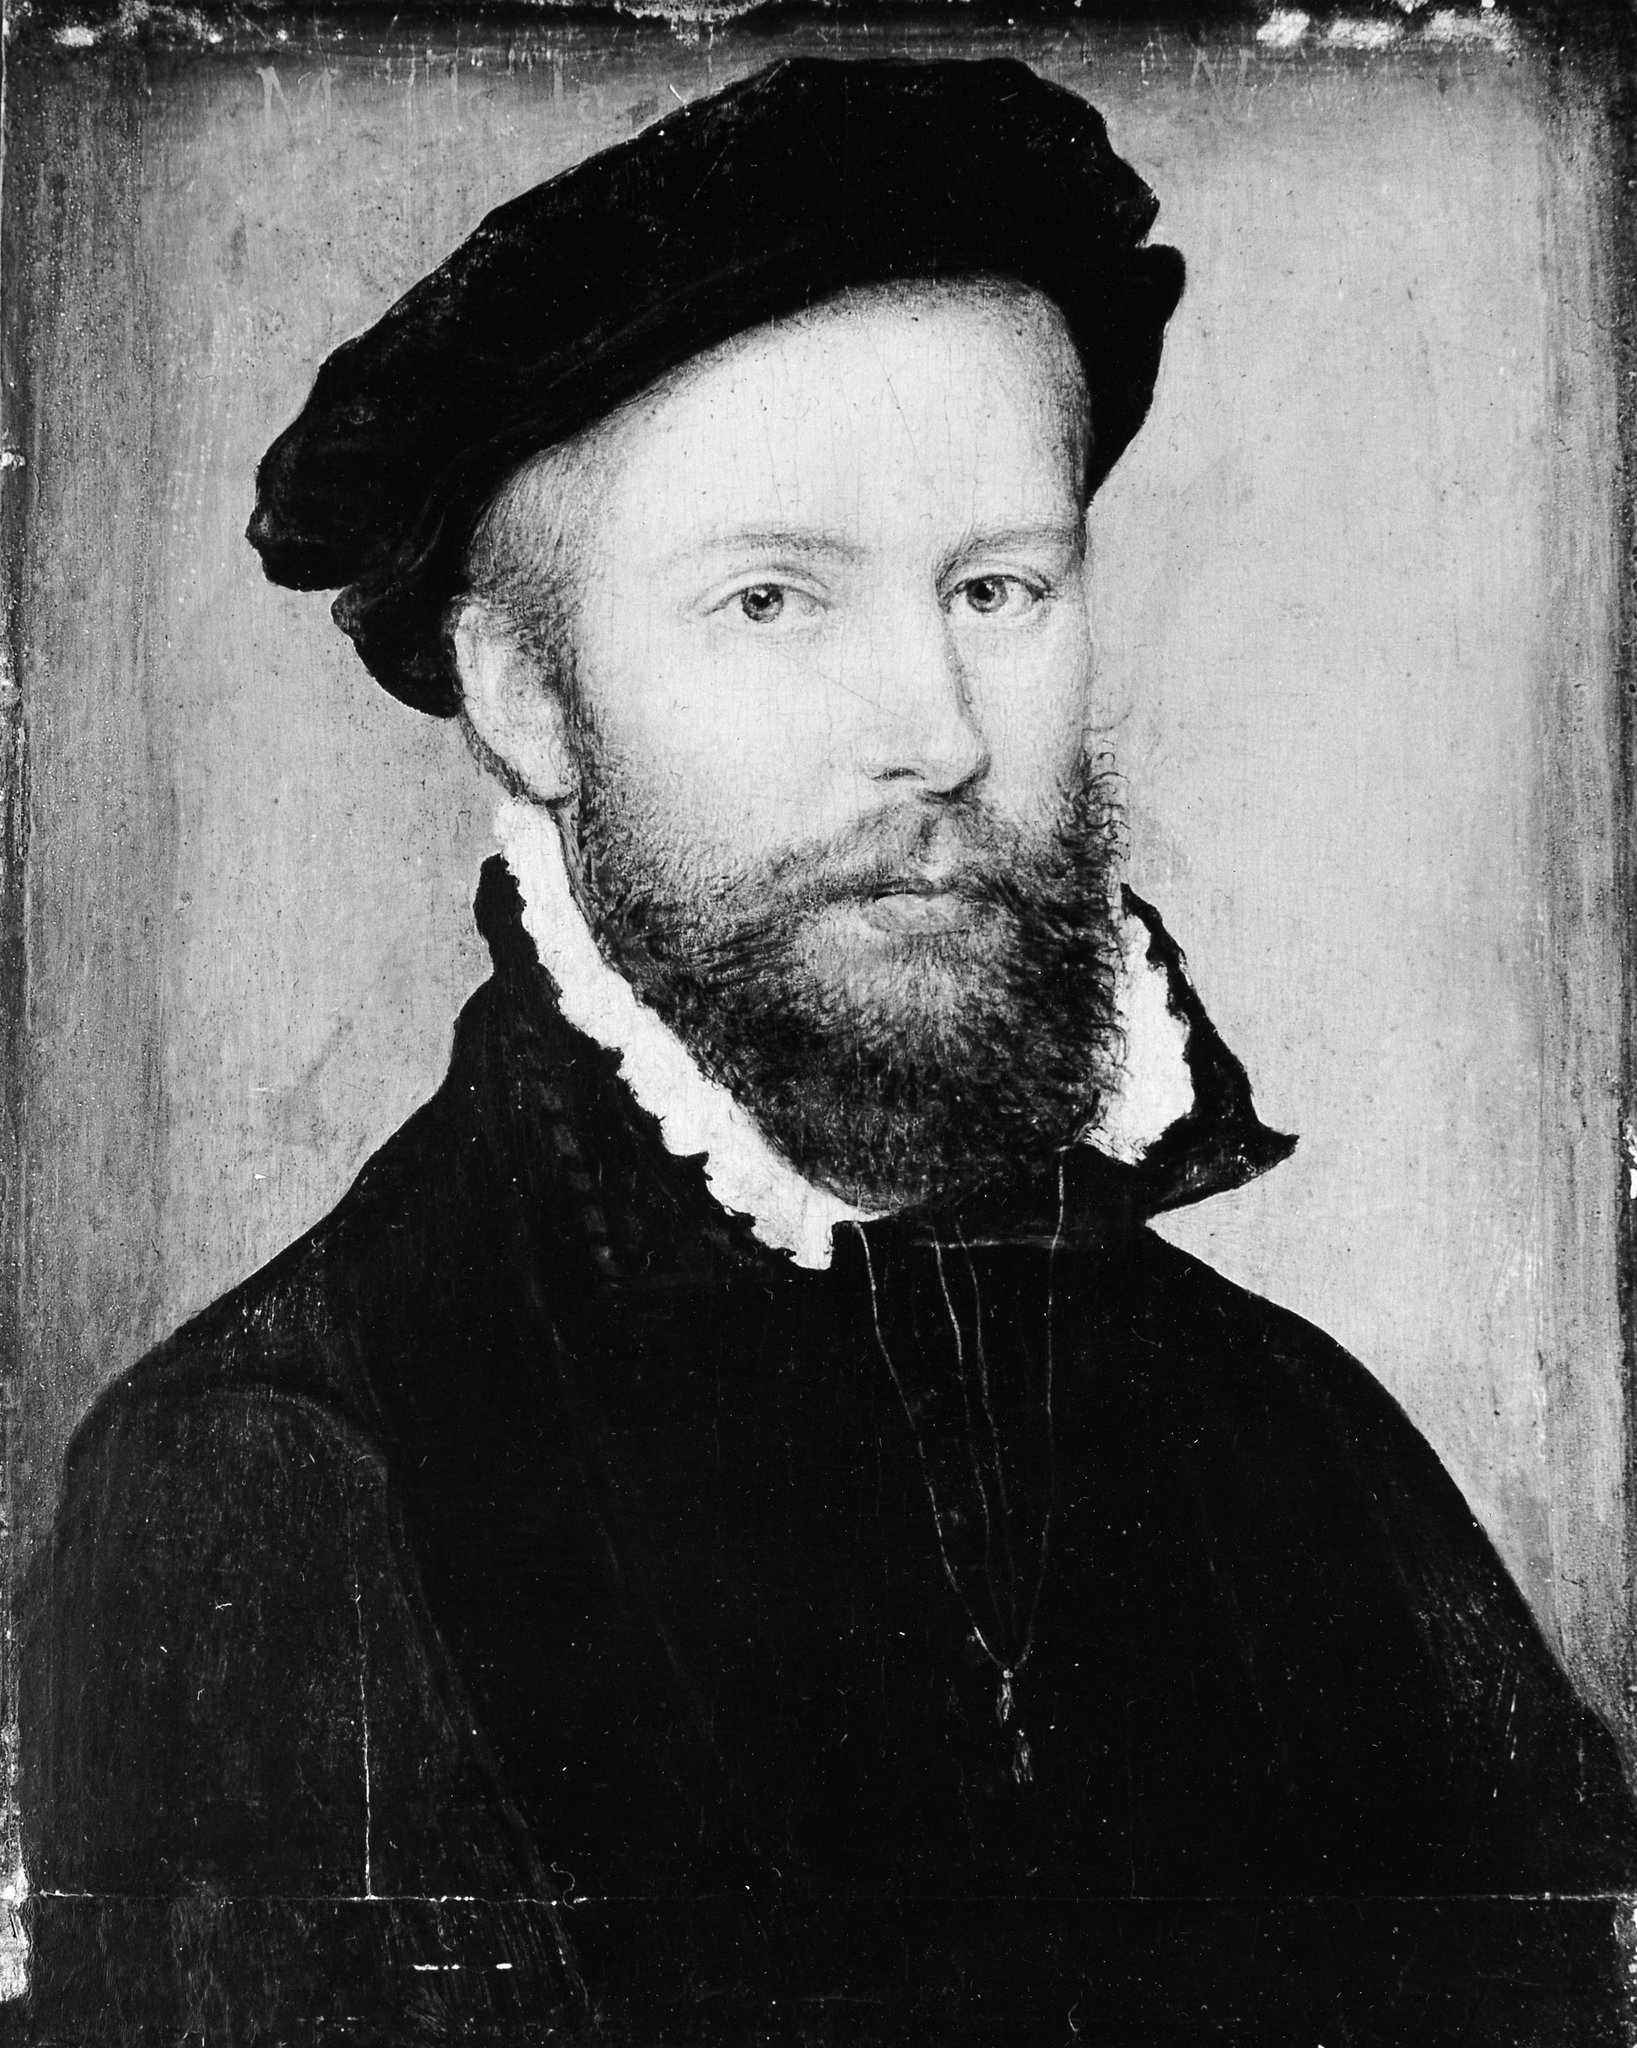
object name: painting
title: Portrait of a Man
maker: corneille de lyon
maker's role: artist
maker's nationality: netherlandish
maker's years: 1533-1575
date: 1533-1575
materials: oil, wood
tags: men,portraits